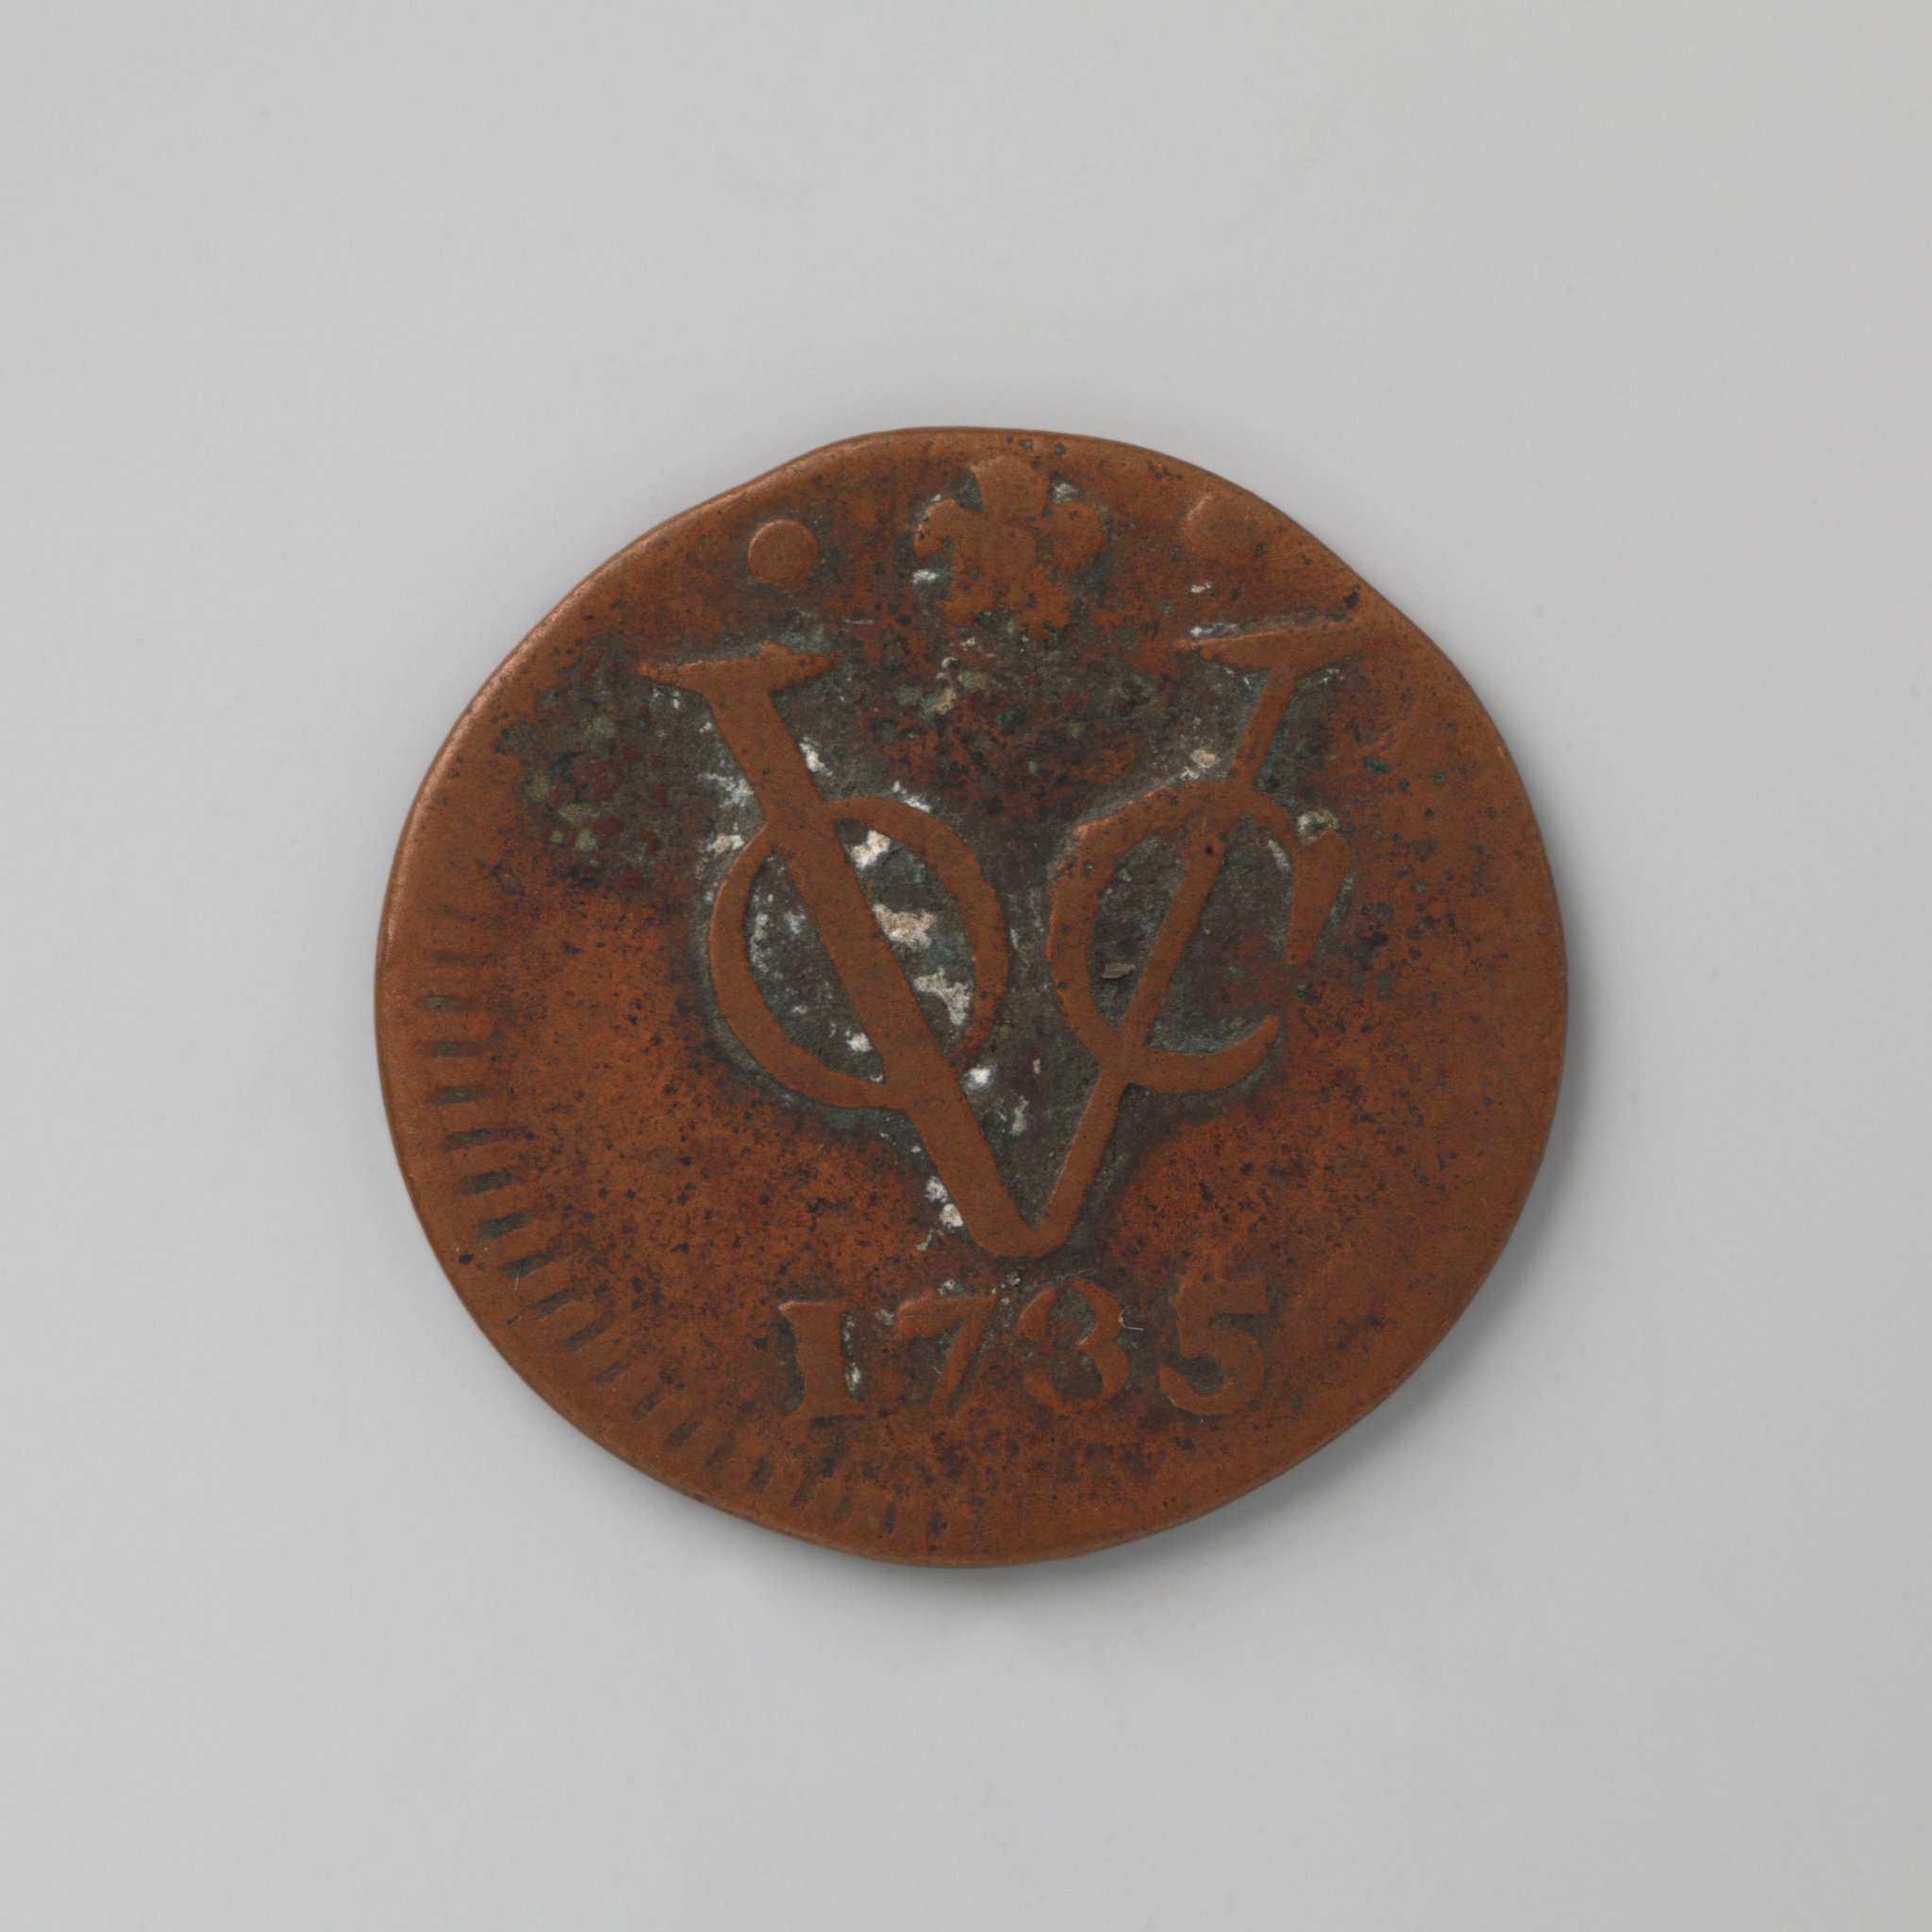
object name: coin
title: VOC, duit Holland, 1735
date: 1735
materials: copper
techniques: striking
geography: dordrecht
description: Koperen munt. Voorzijde: gekroond wapenschild van Holland. Keerzijde: monogram van de VOC, waarboven muntteken en waaronder jaartal. Gladde rand.